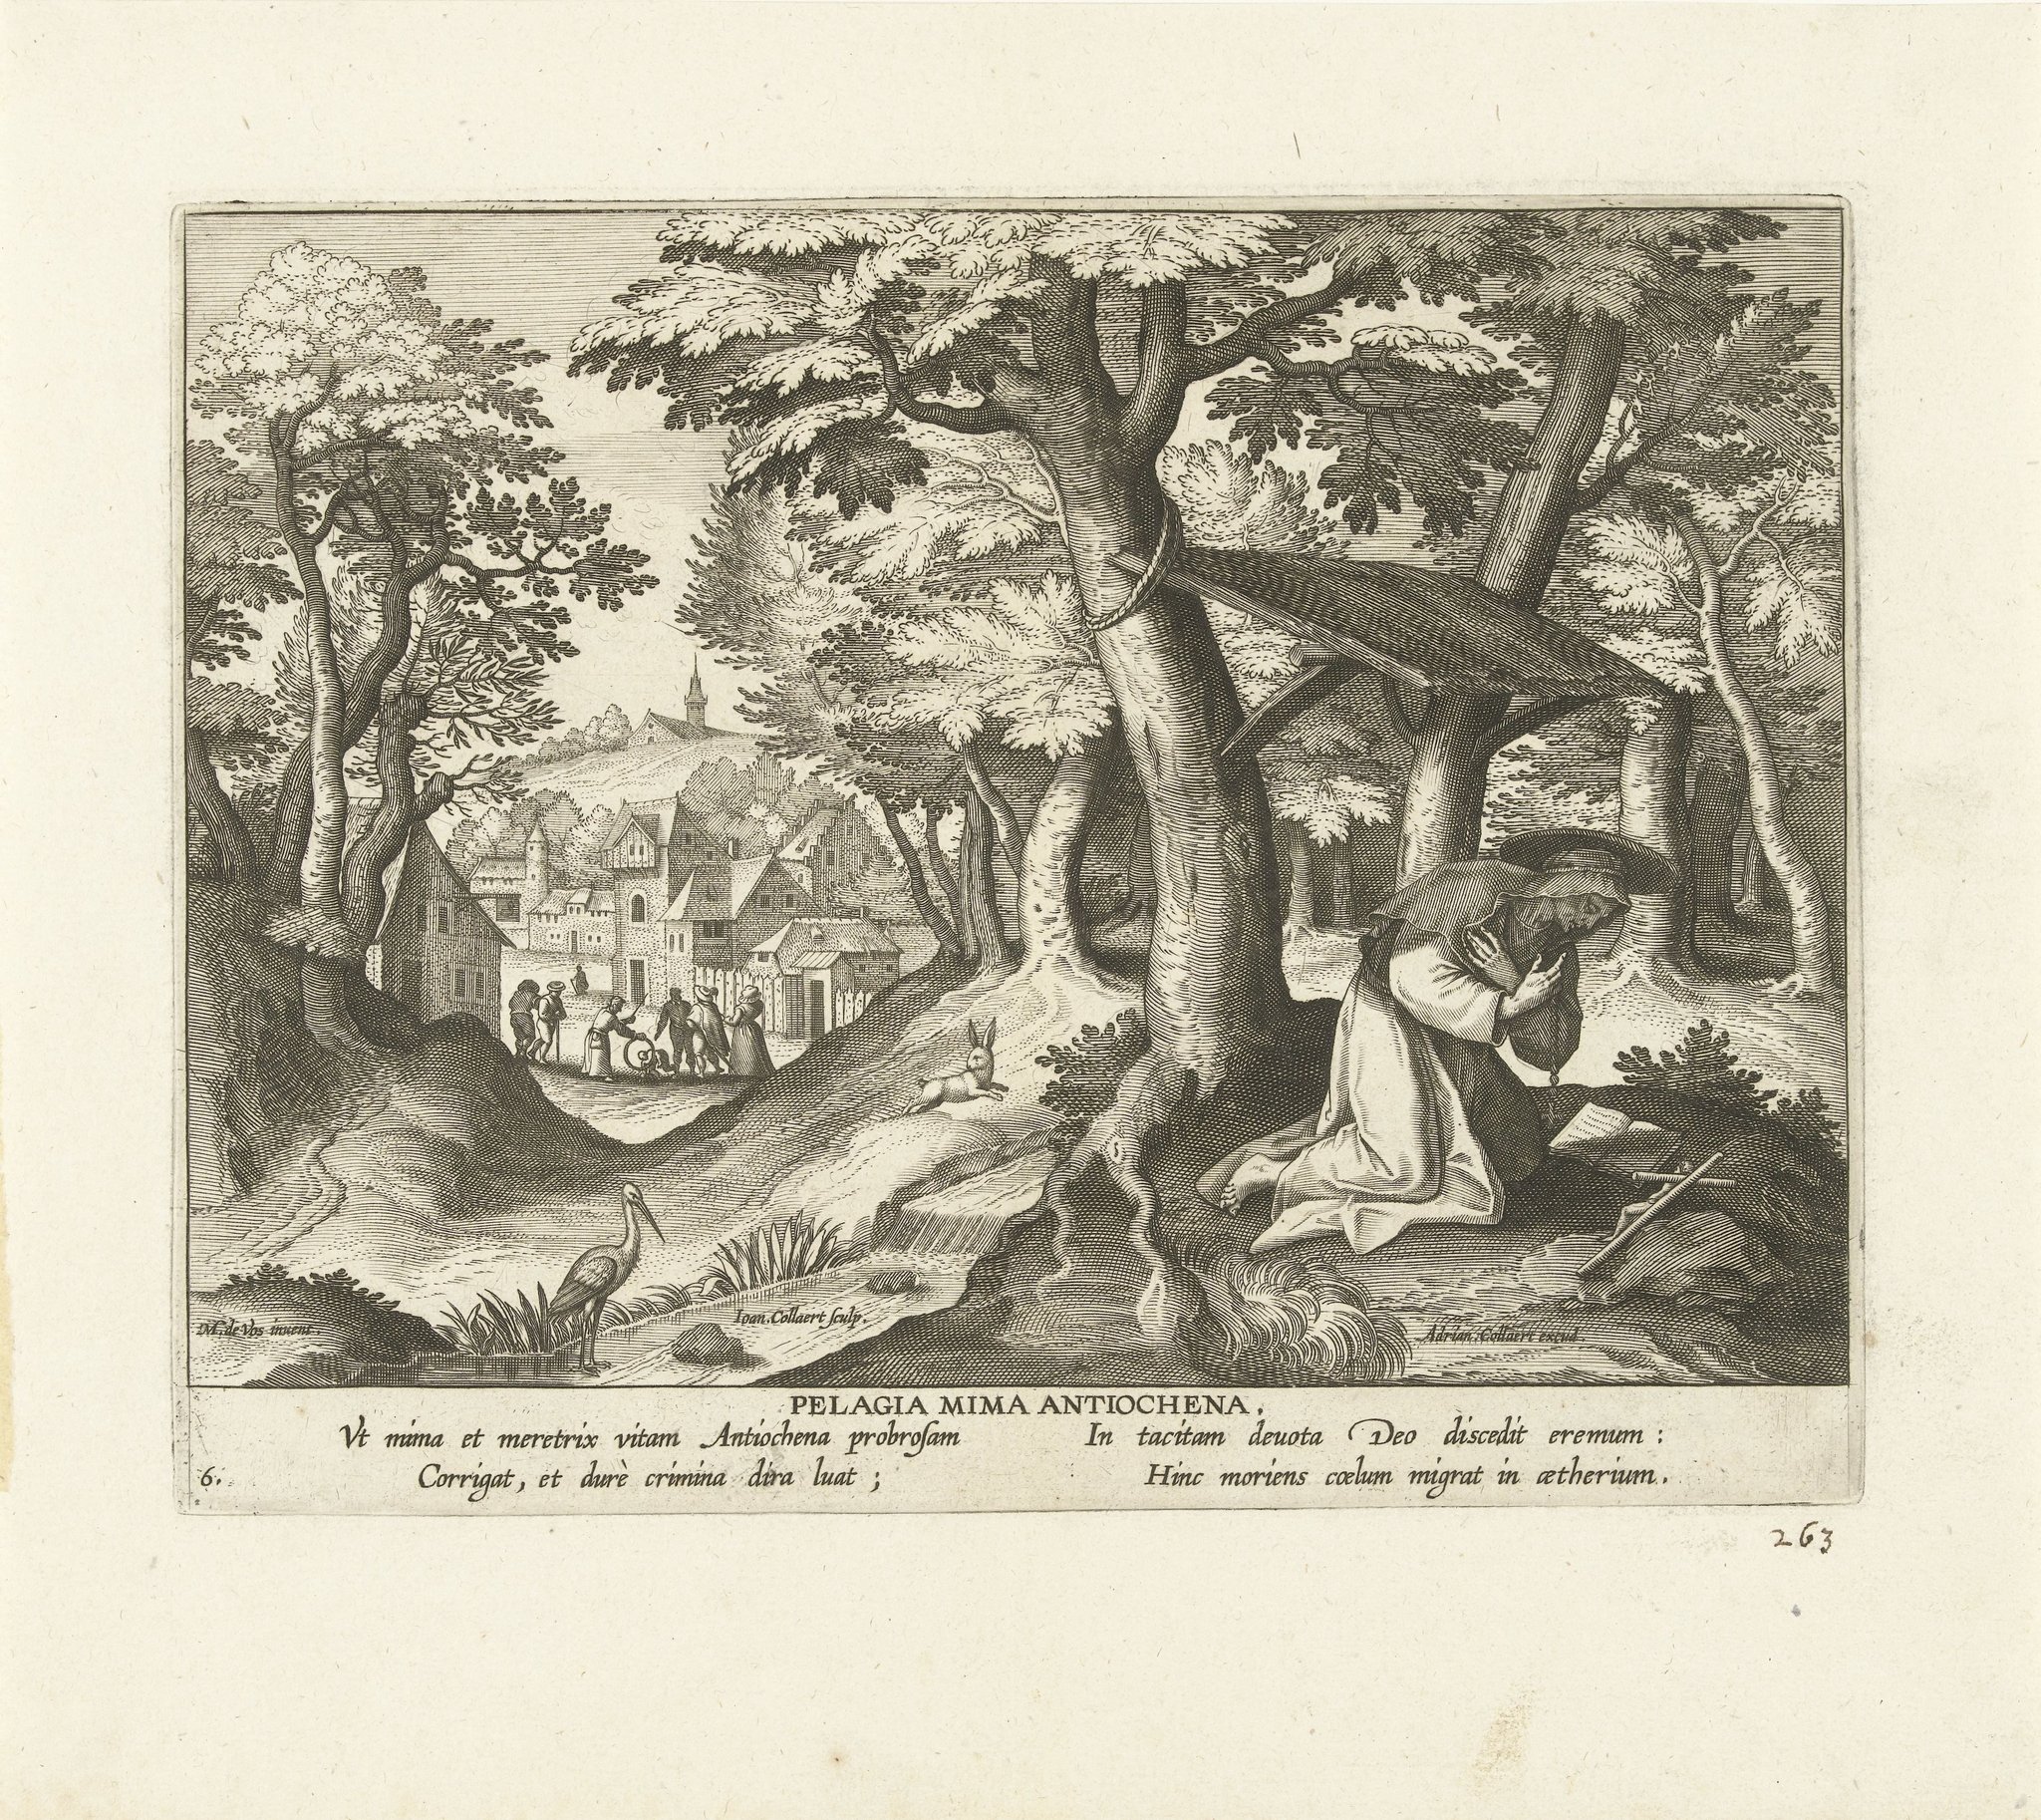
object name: print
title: Solitvdo sive vitae foeminarvm anachoritarvm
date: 1570-1618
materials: paper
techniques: engraving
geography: antwerp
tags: anchorite, hermit, female saints (with name)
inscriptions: collector's mark: Lugt 2228, number: ‘263’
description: Pelagia Mima van Antiochië knielt voor een kruisbeeld in de wildernis. Op de achtergrond een stad. De prent heeft een Latijns onderschrift en maakt deel uit van een serie uit vierentwintig prenten met als onderwerp vrouwelijke kluizenaars.